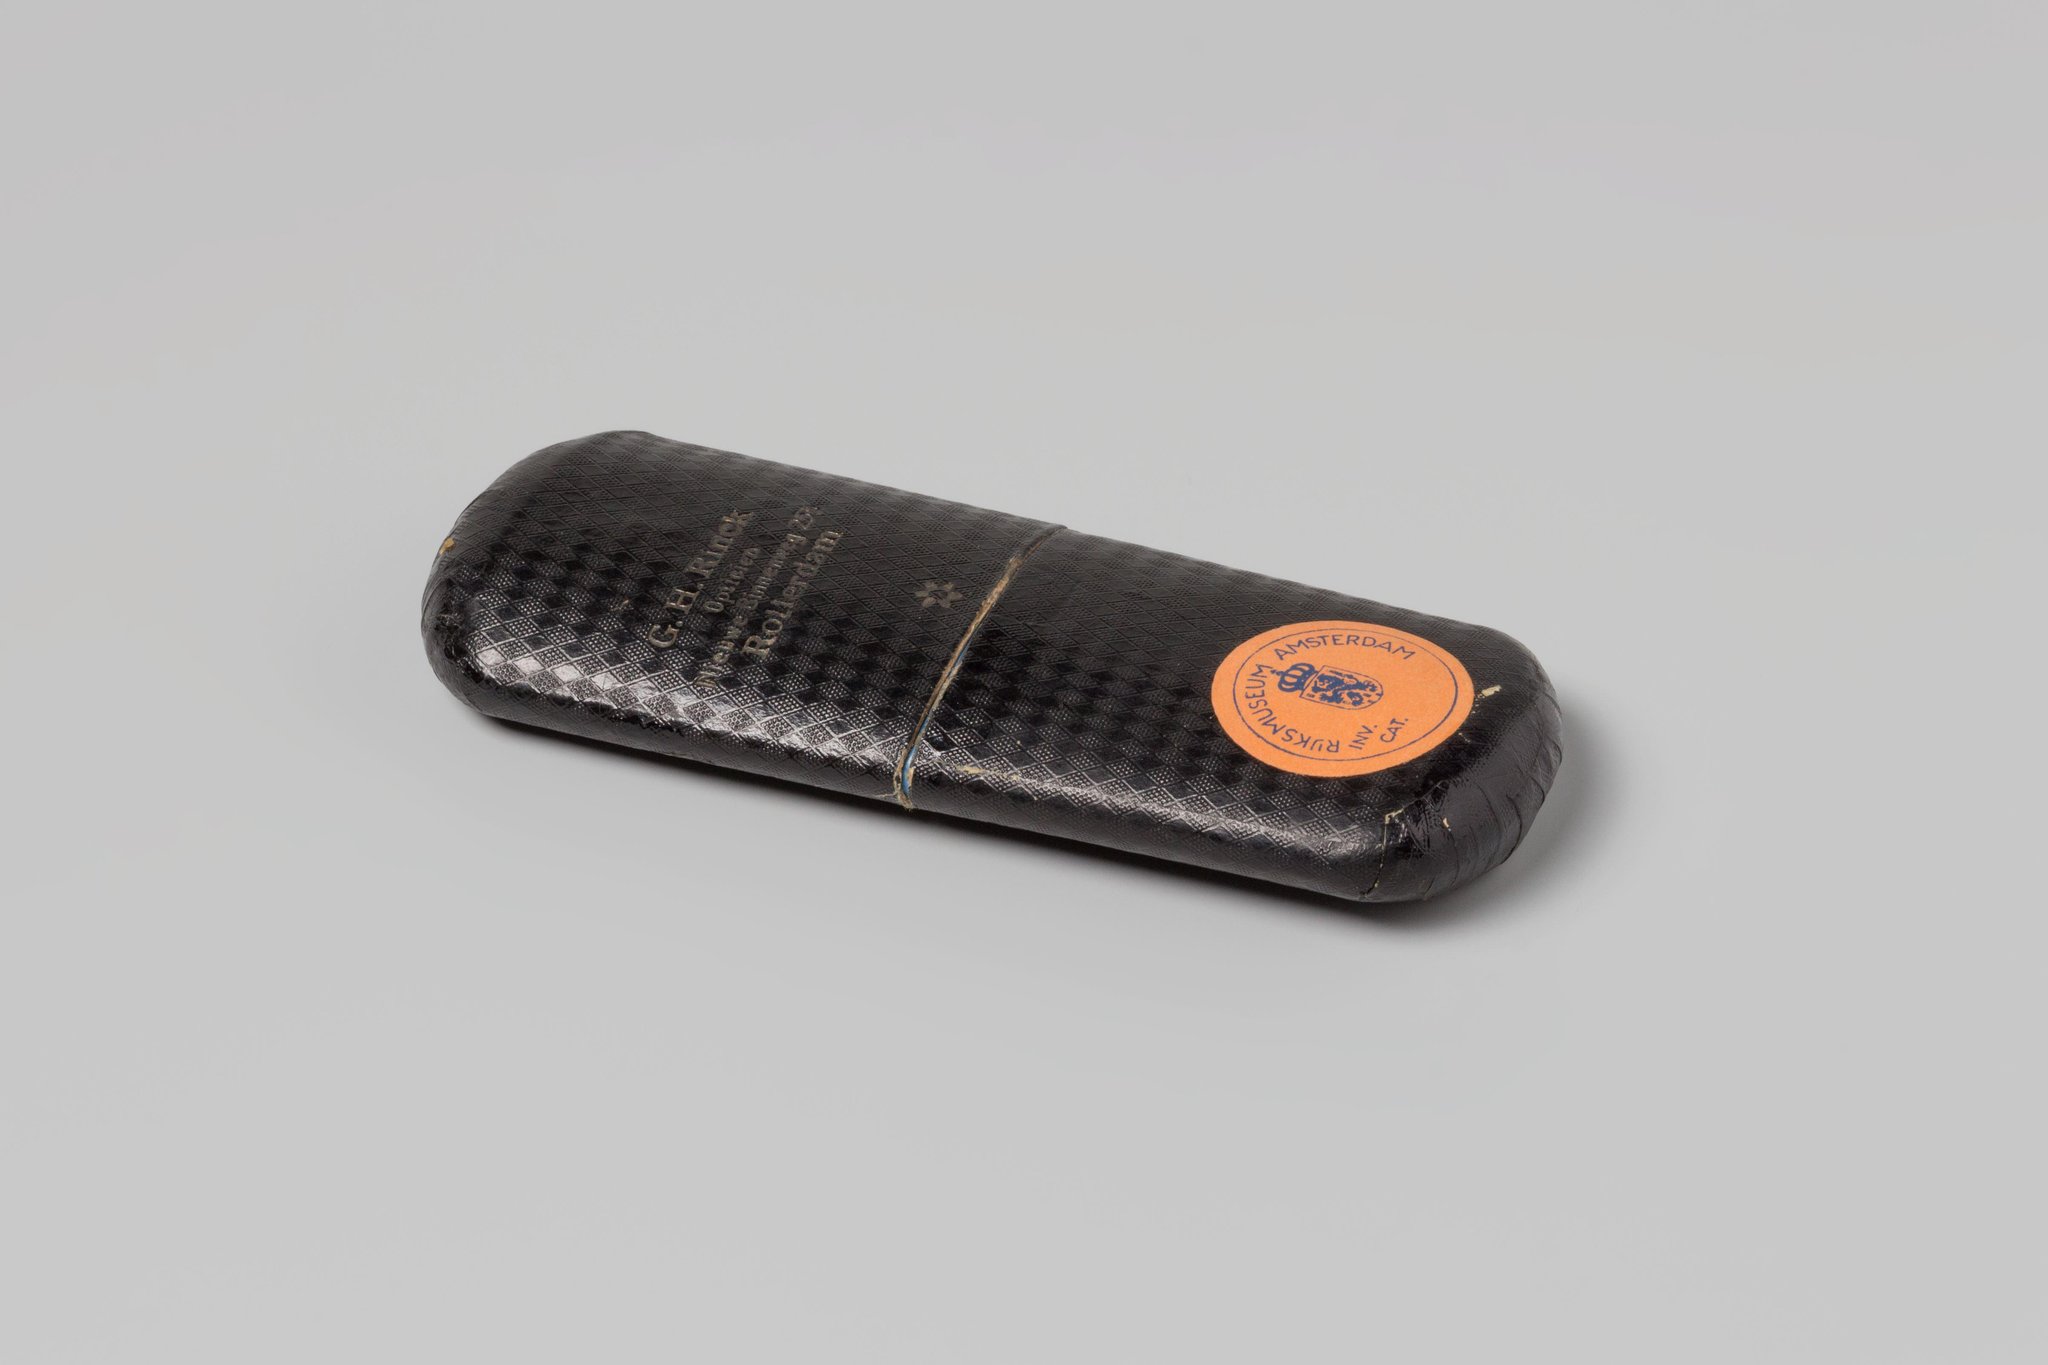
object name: brillenkoker, brillenetui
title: Brillenetui, langwerpig met afgeronde hoeken, bekleed met zwart geruit papier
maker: Anonymous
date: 1830-1840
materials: paper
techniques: pasting, scooping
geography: netherlands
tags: eyeglasses, spectacles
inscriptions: address: ‘G.H. Rinck // Opticien // Nieuwe Binnenweg 253 // Rotterdam’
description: Brillenetui van dik papier, langwerpig met afgeronde hoeken, bekleed met zwart geruit papier. Zilverkleurige opdruk: G.H. Rinck // Opticien // Nieuwe Binnenweg 253 // Rotterdam.